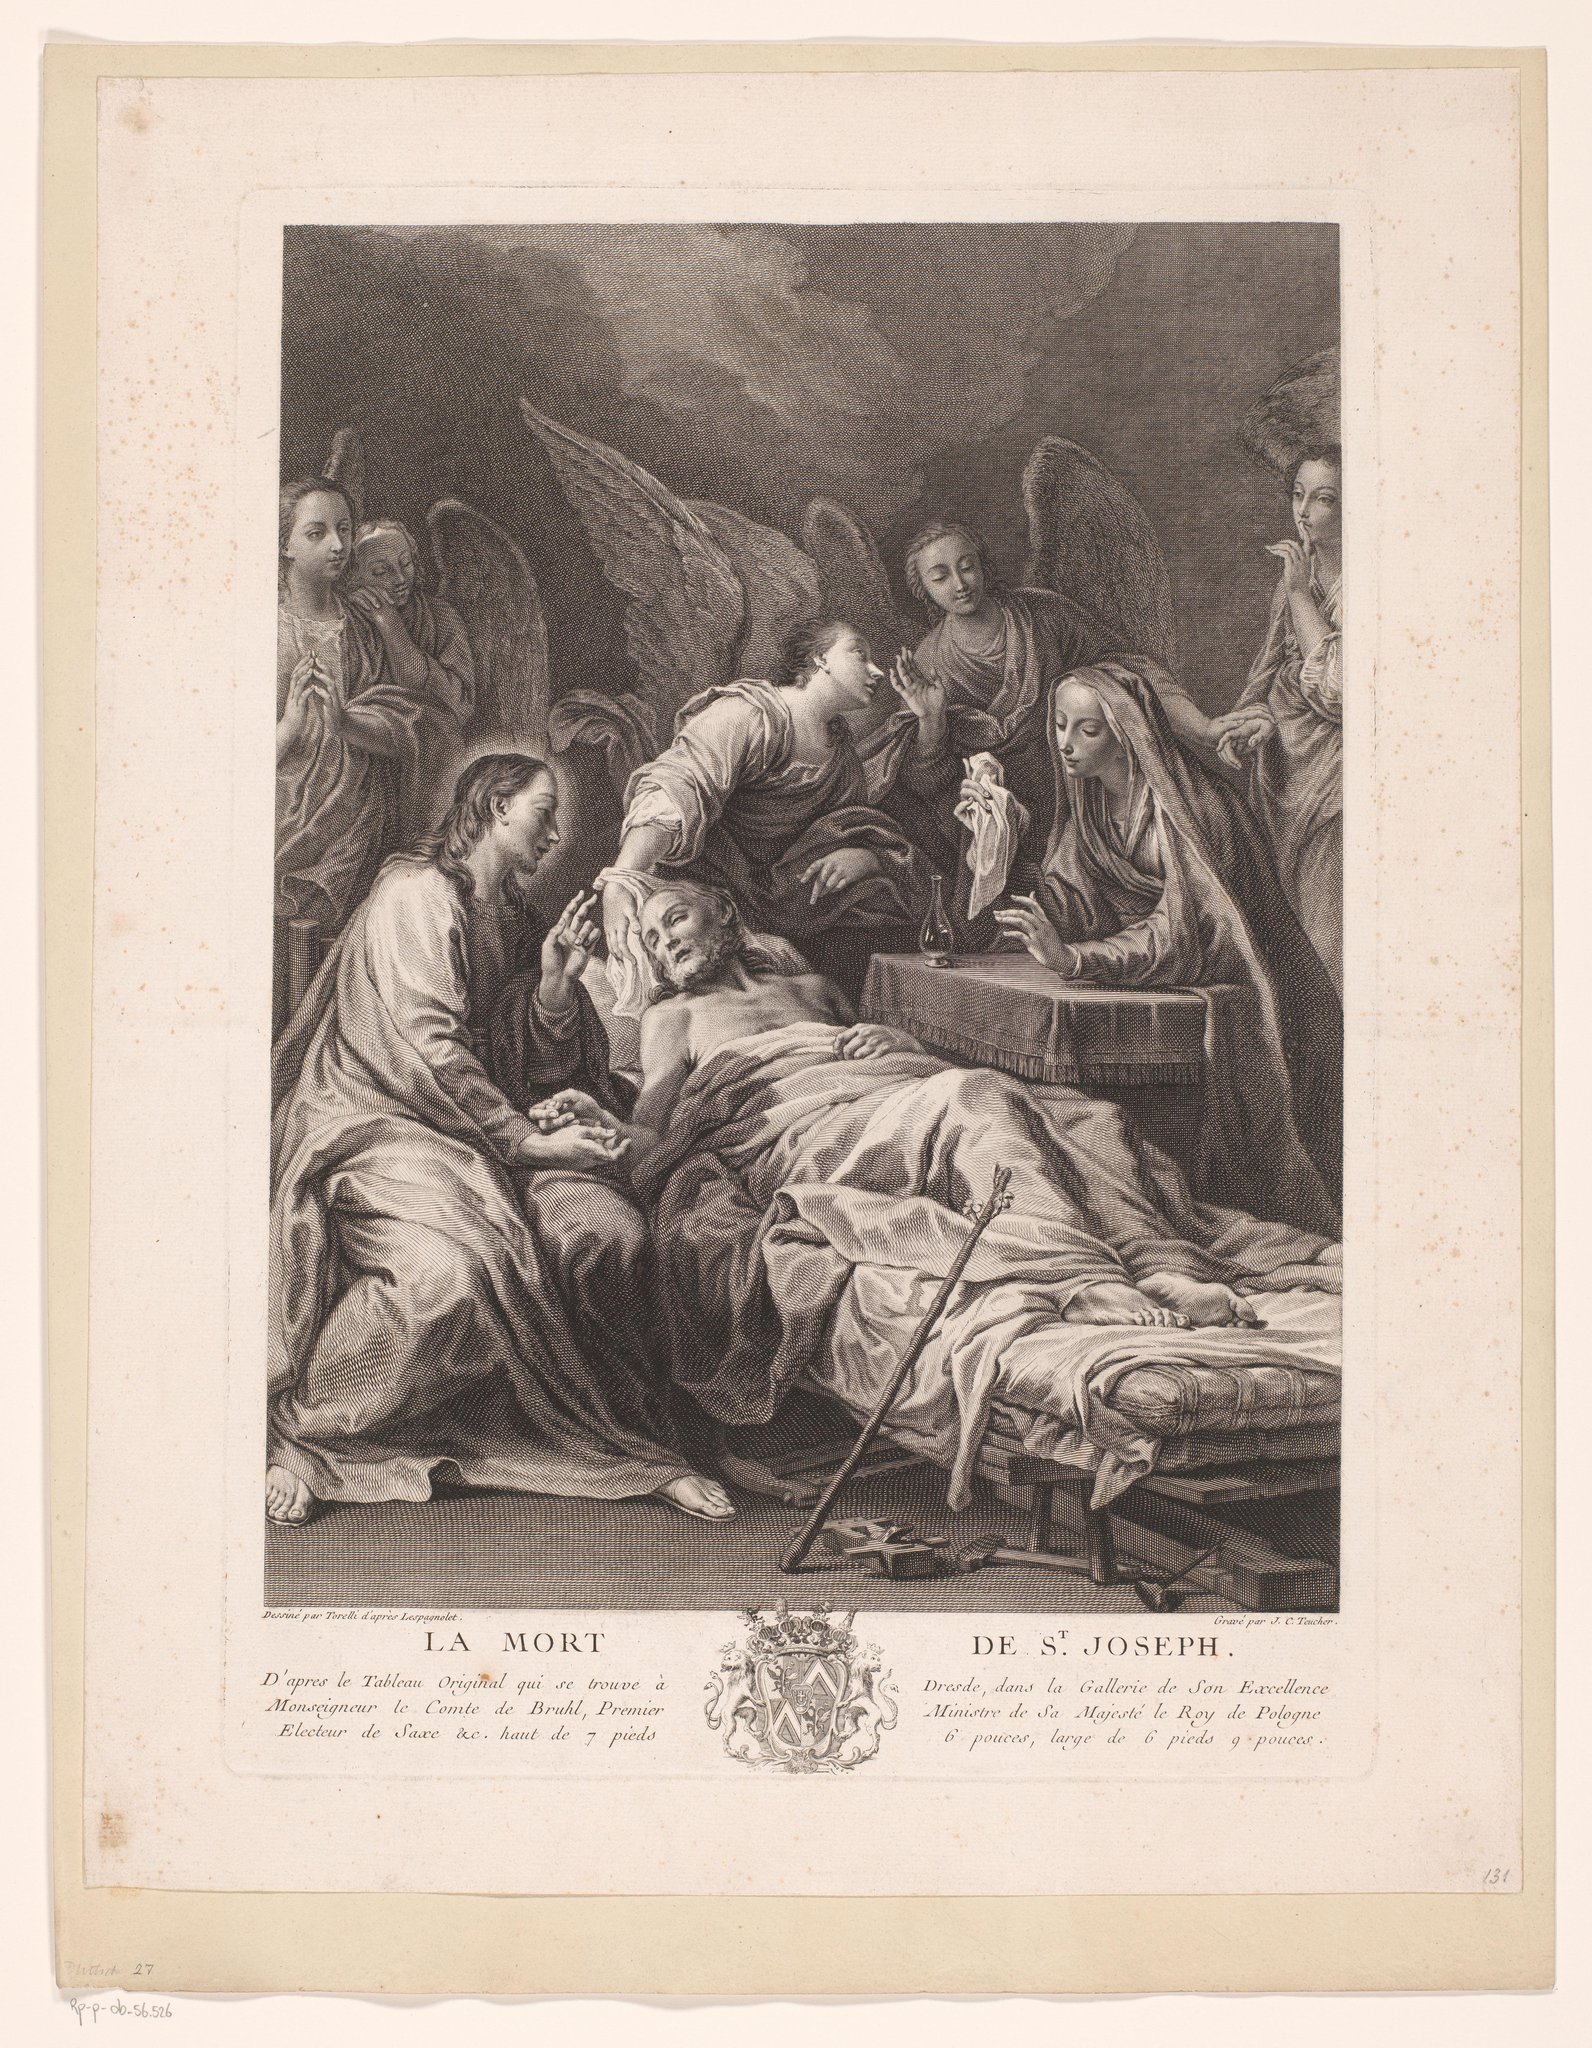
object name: print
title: Sterfbed van Jozef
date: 1725-1763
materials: paper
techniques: engraving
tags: joseph's death, armorial bearing, heraldry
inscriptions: collector's mark: Lugt 240